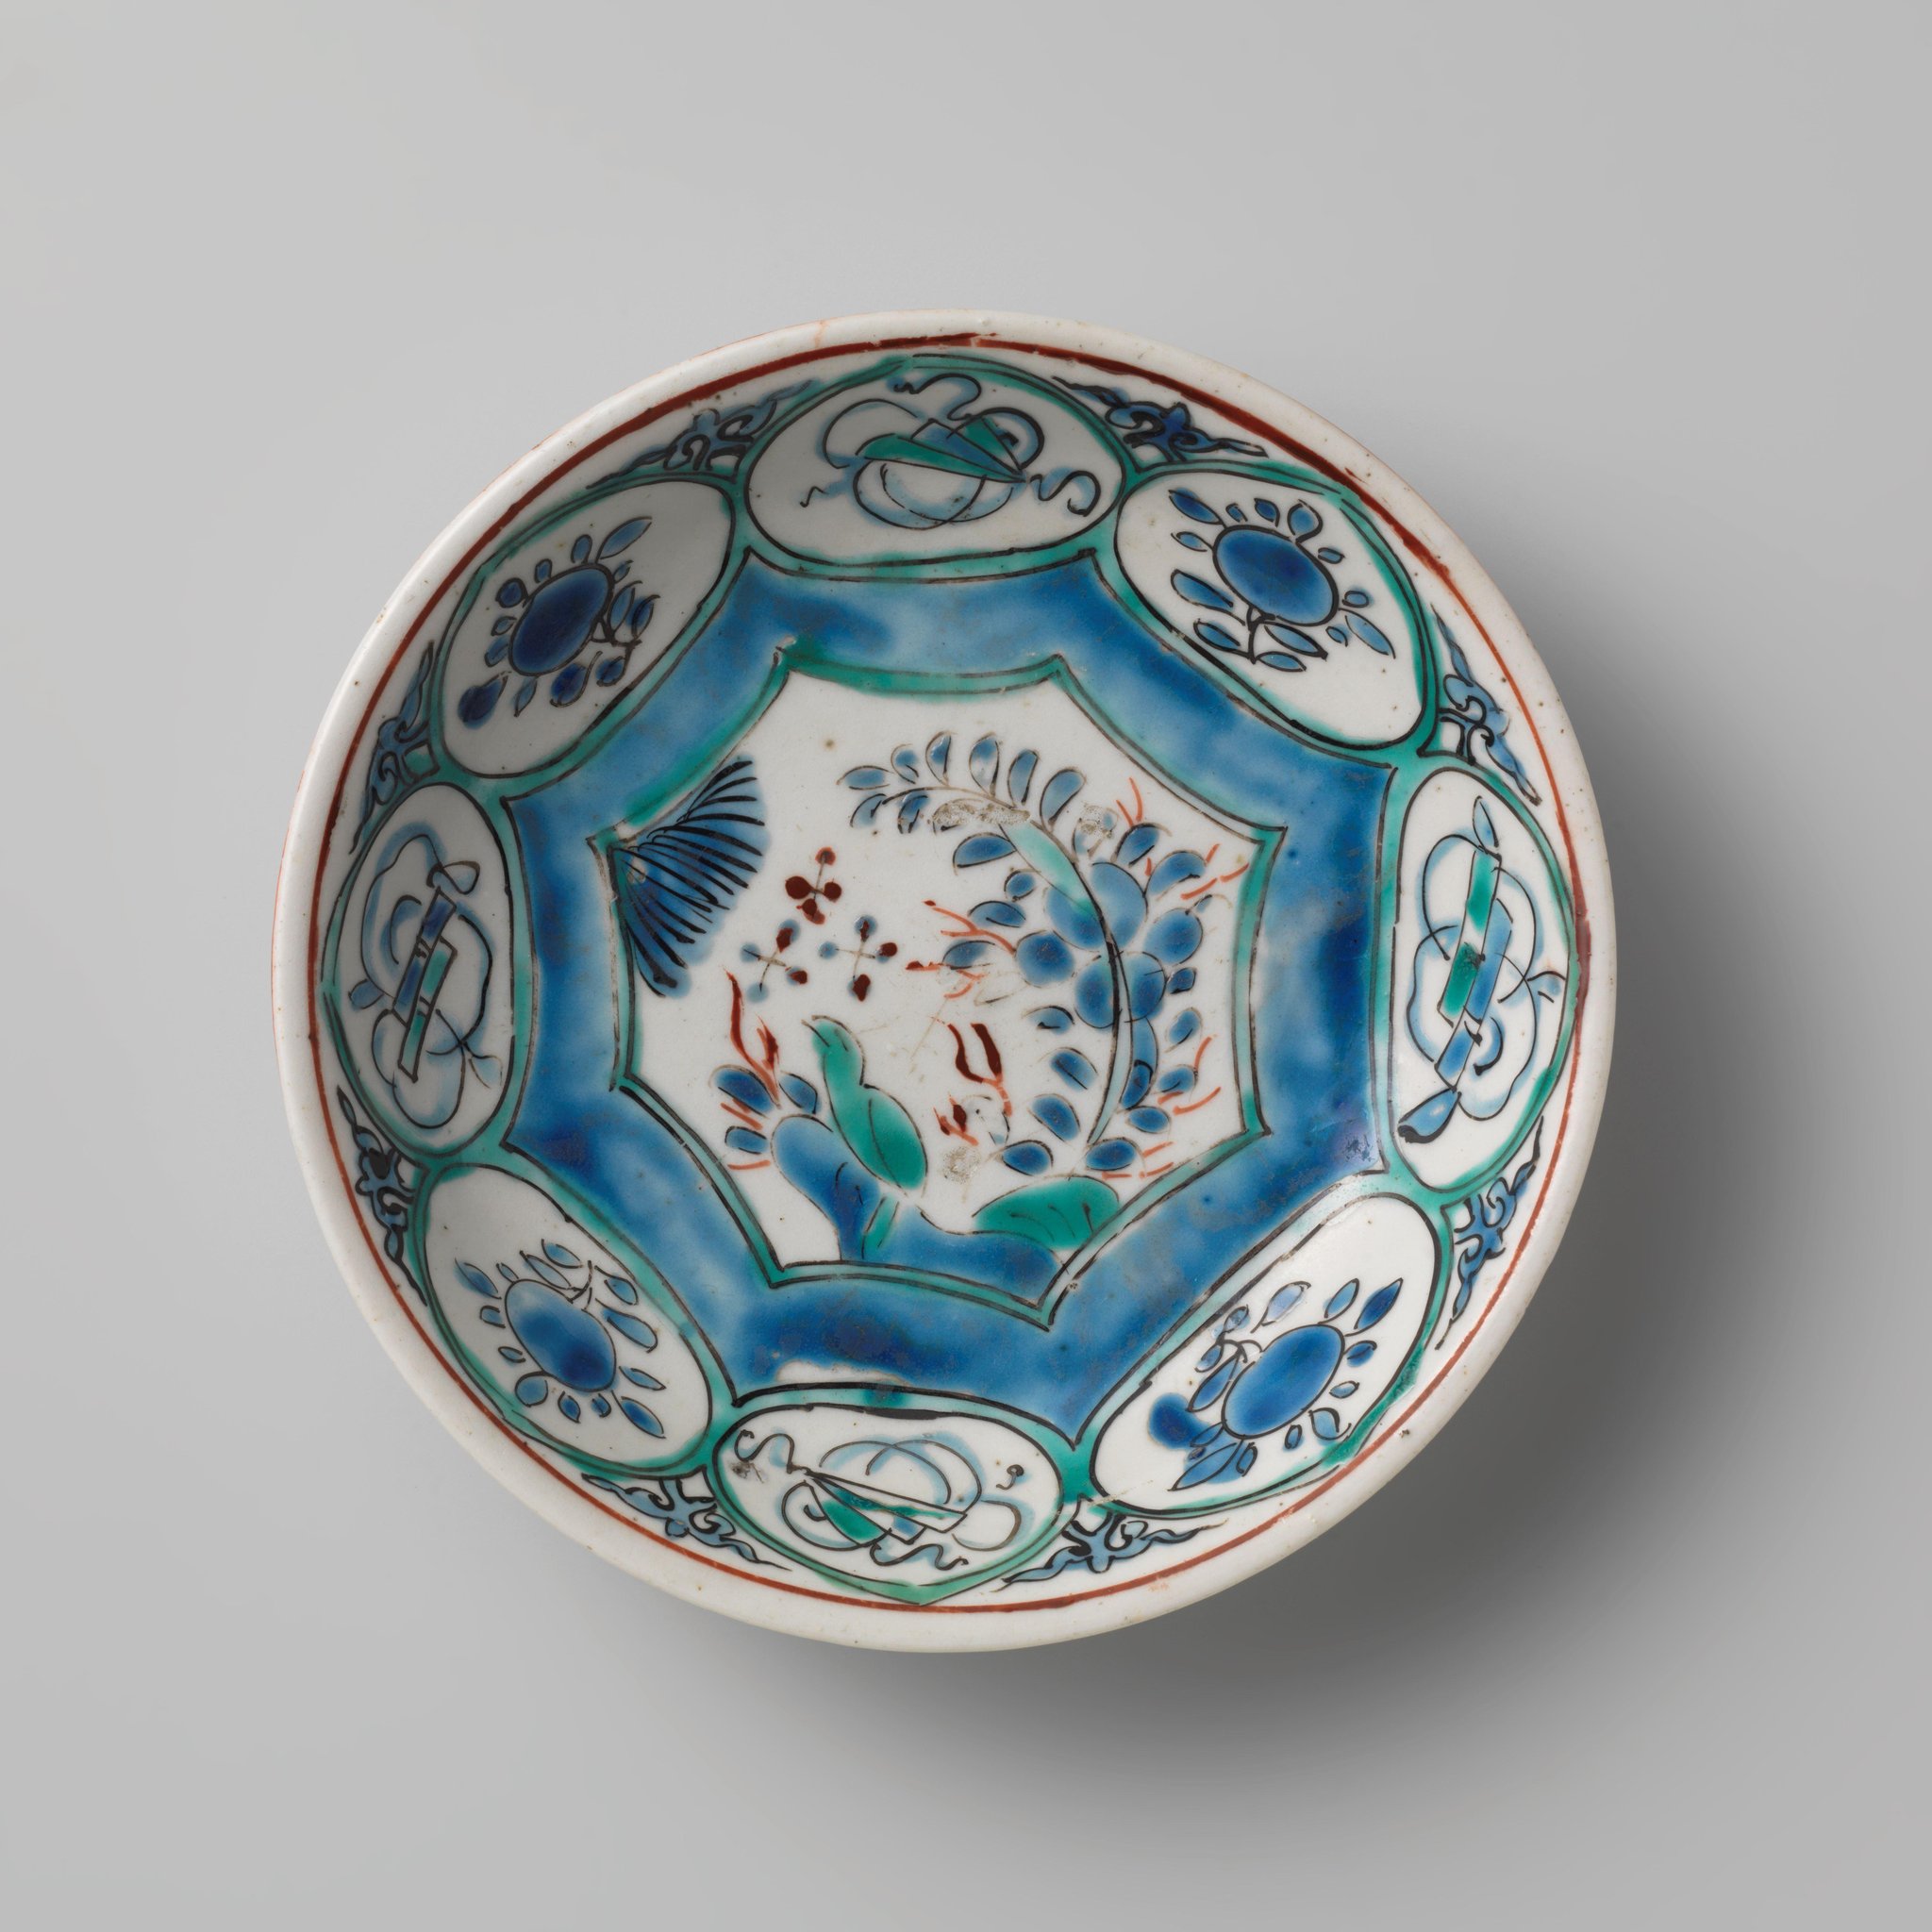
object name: dish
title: Saucer-dish with a bird on a rock, flower sprays and auspicious objects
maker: Anonymous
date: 1650-1699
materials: cobalt, glaze, paint, porcelain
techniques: firing, turning, vitrification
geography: japan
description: Plate. Early enamelled. Japan, Arita, c. 1660 - 1680. Porcelain, decoration in enamels.